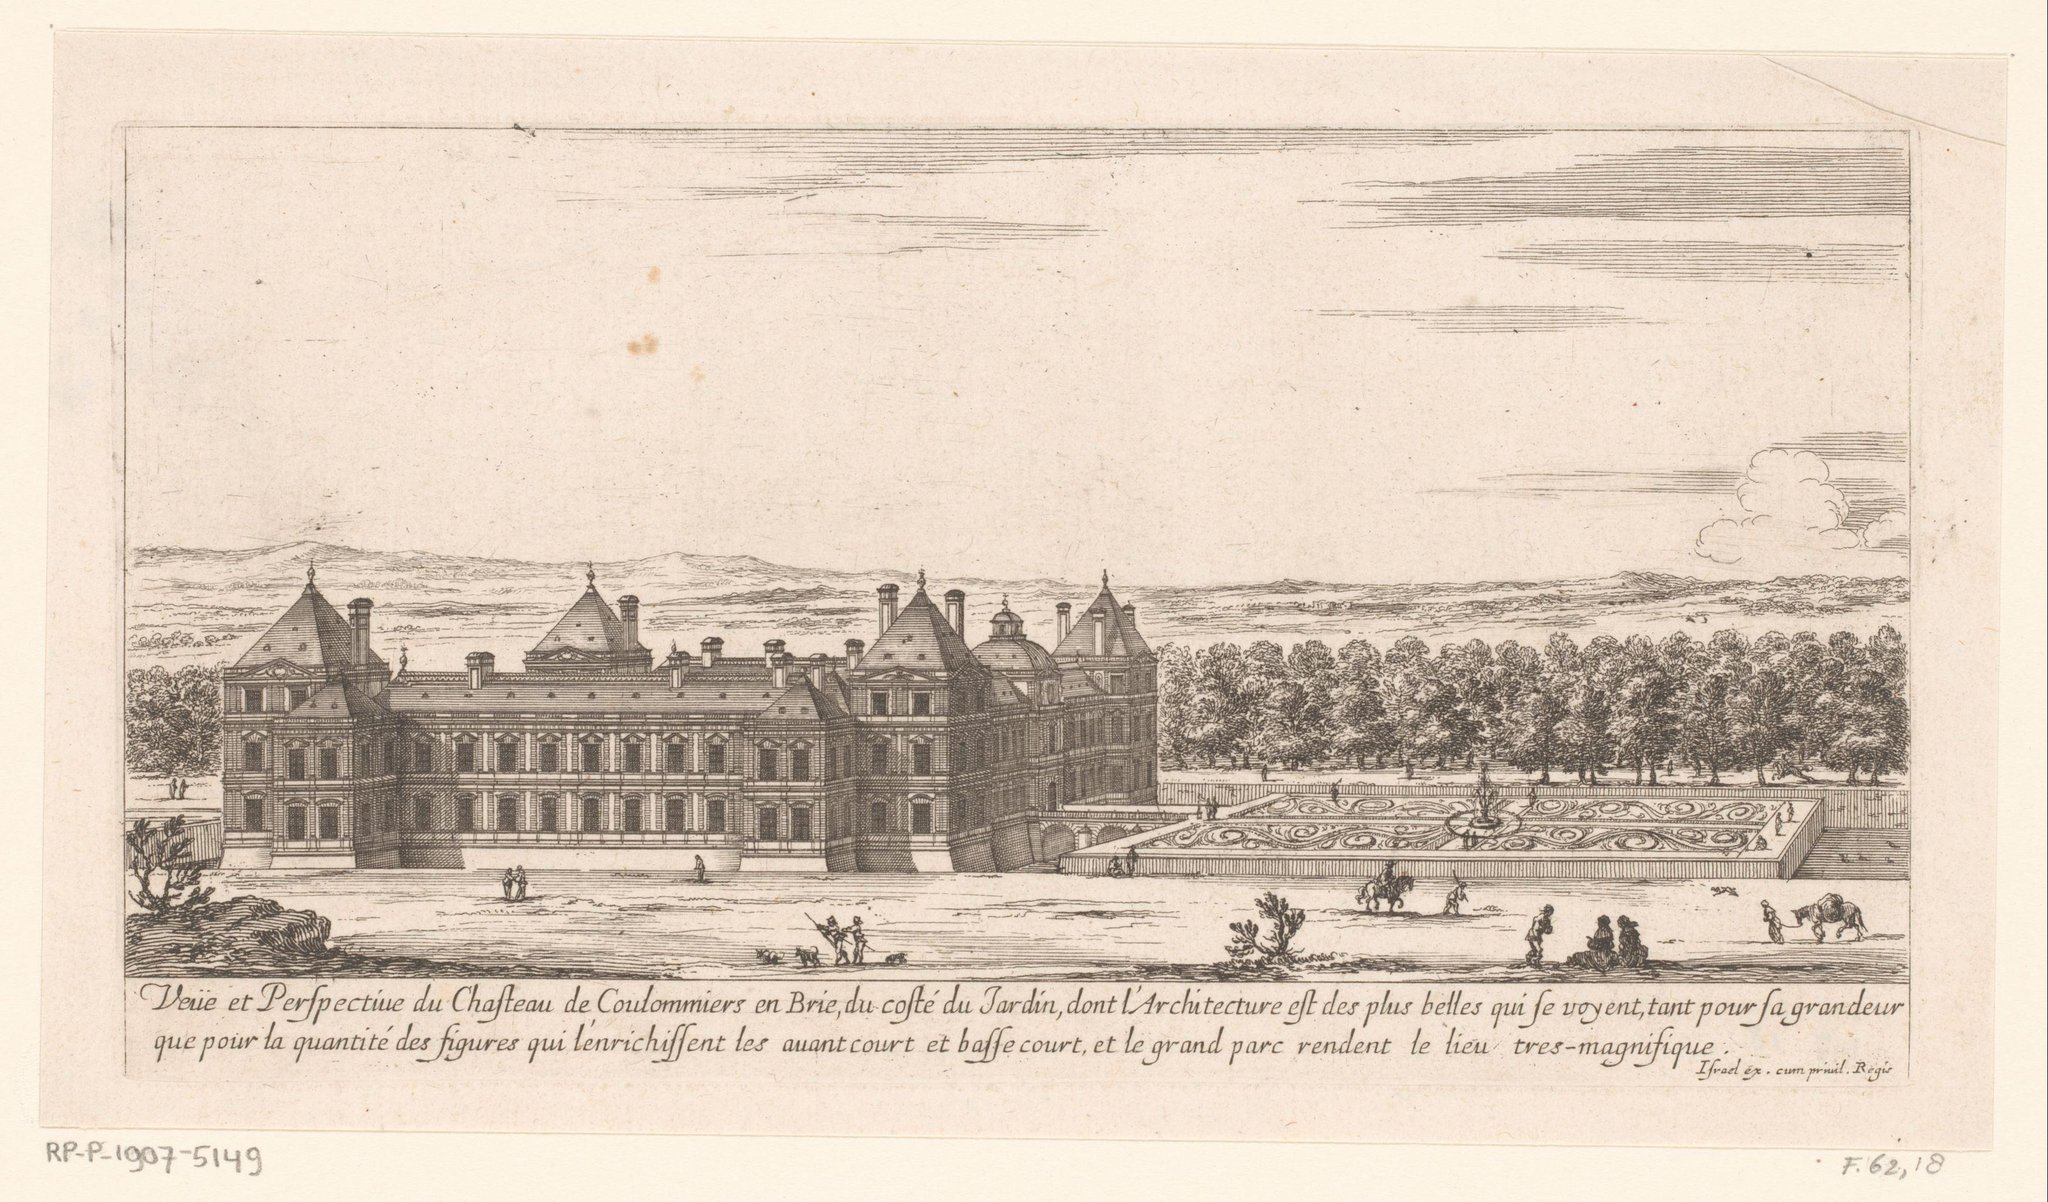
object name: print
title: Gezichten op diverse kastelen en landschappen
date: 1651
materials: paper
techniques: engraving, etching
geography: france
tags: french or architectonic garden; formal garden, landscape with tower or castle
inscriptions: collector's mark: Lugt 2228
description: Prent maakt deel uit van een ongenummerde serie van 22 prenten.